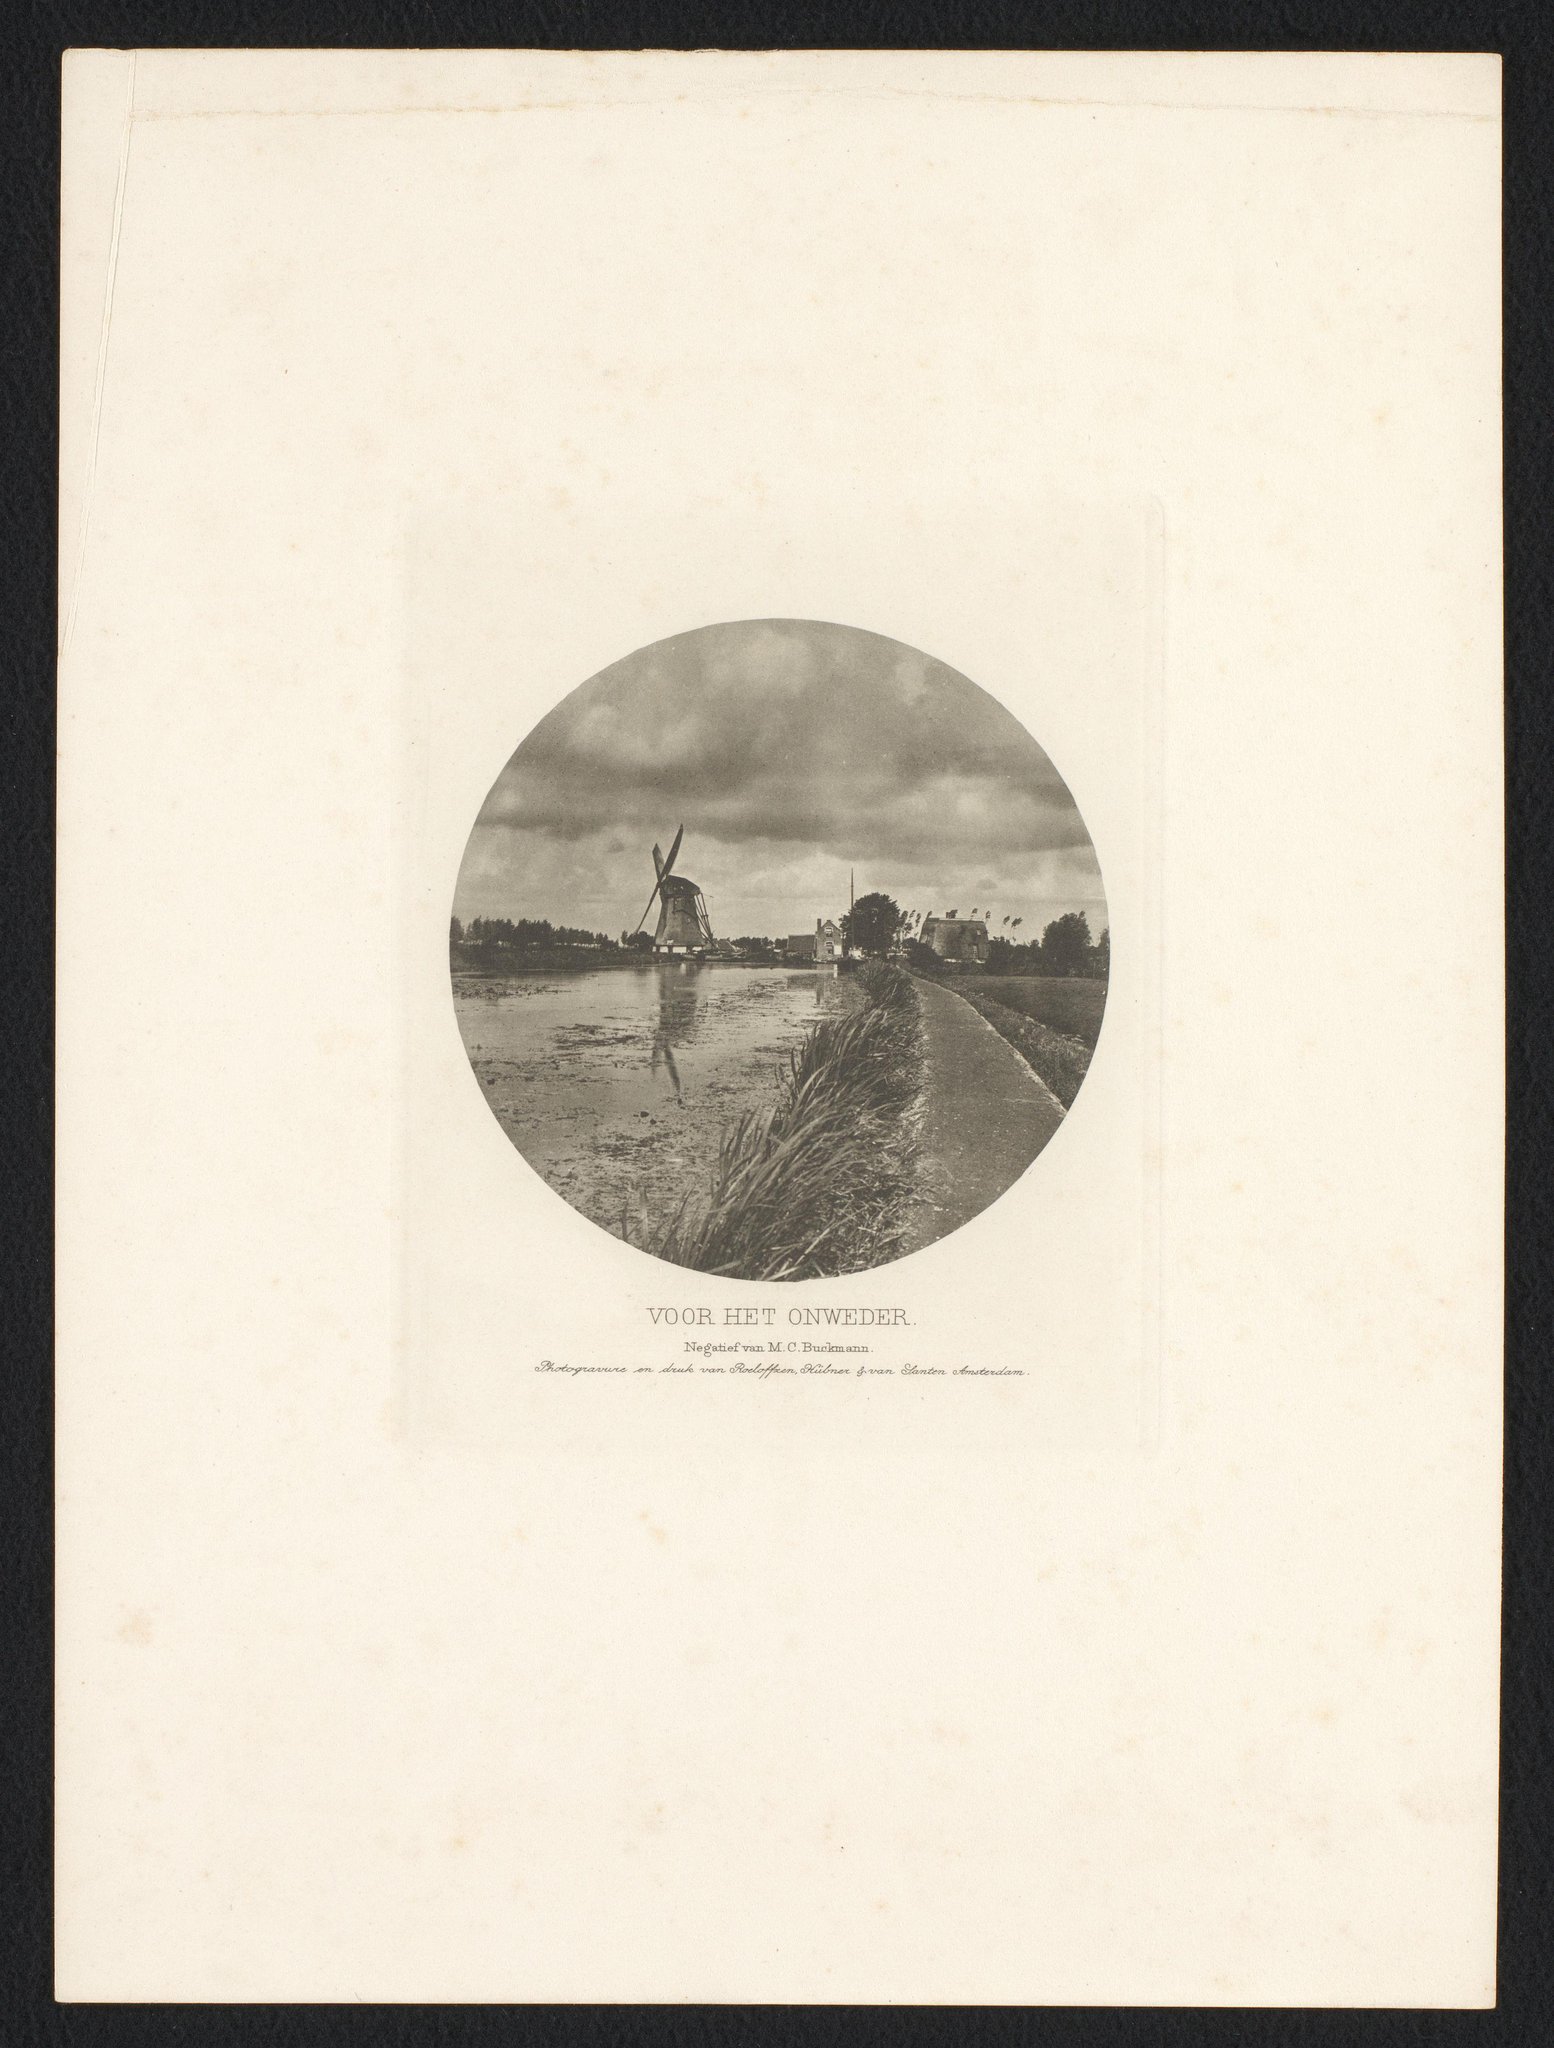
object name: page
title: Gezicht op de polder bij de voormalige gemeenten Reeuwijk (links) en Sluipwijk (rechts), ten noordoosten van Gouda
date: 1898-1903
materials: paper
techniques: photoaquatint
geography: amsterdam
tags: water course, village, windmill in landscape